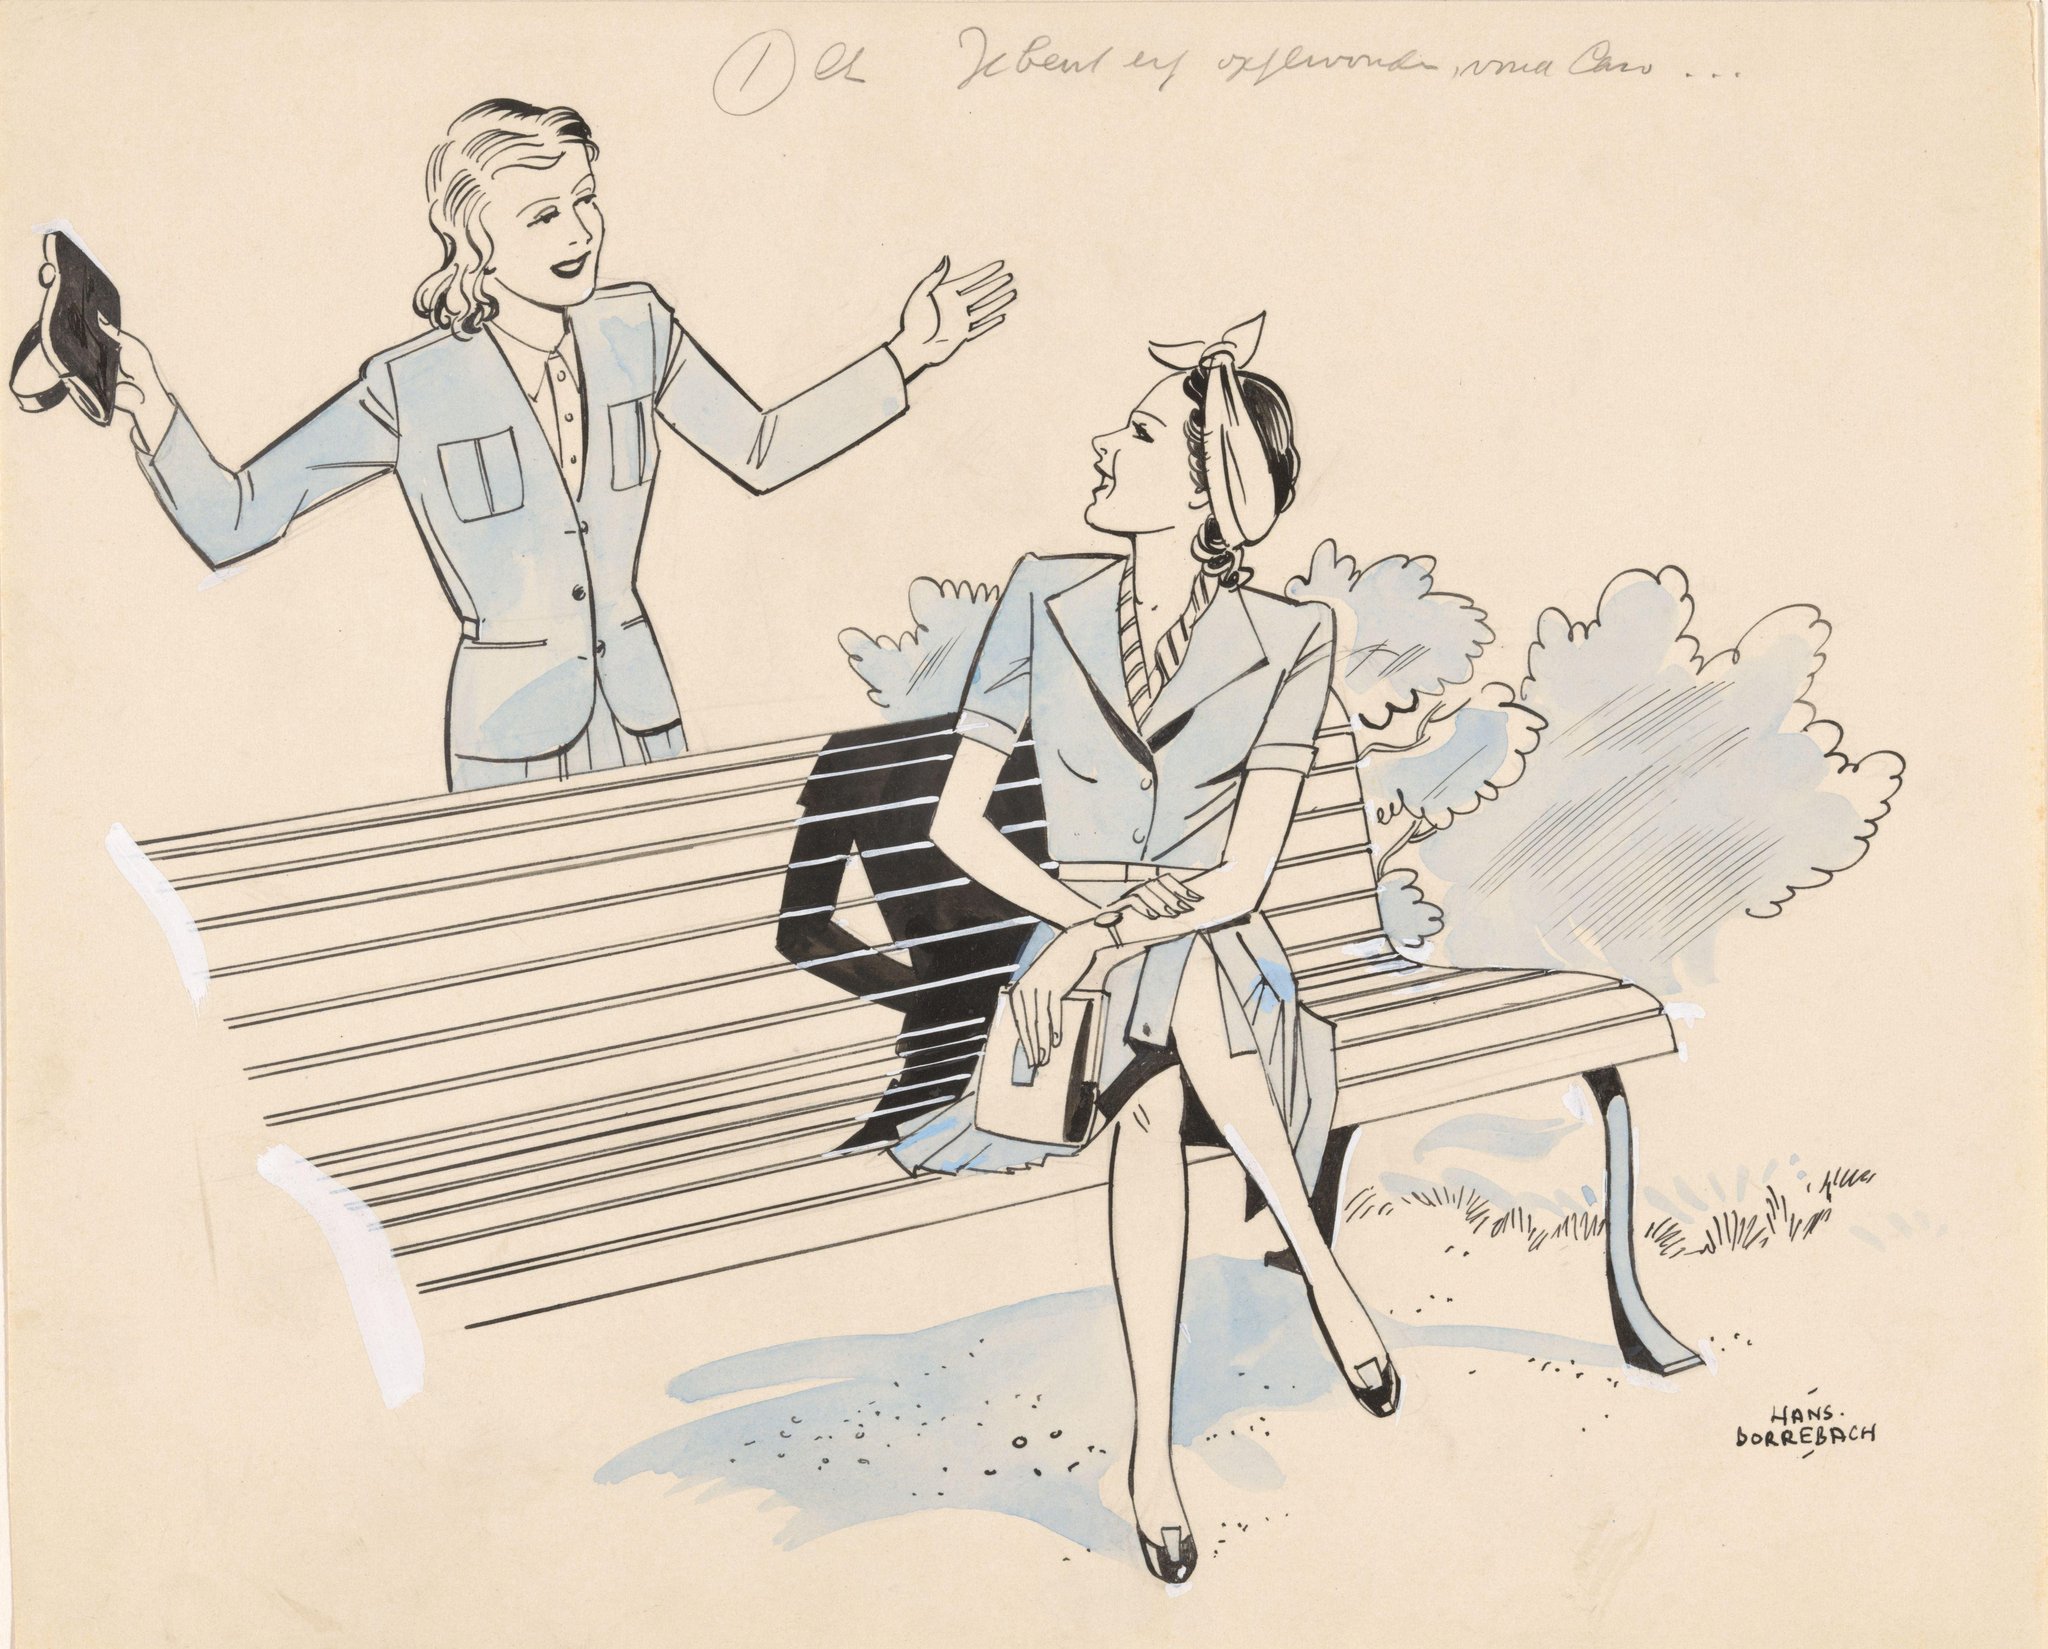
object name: boekillustratie ontwerp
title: Twee vrouwen in gesprek in een park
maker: hans borrebach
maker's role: draughtsman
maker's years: 1903-1991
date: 1940-1945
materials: paint, ink, paper, pencil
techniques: brush, pen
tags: park, bench, arm raised upward - aa - both arms or hands, conversation, dialogue; conversation piece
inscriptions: signature: ‘HANS./ BORREBACH’, collector's mark: ‘R:MVS’, annotation: ‘1 bl Je bent erg opgewonden, oma Caro . . .’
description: Ontwerp voor: Etten, Ine van. Idylle in de archipel. c. 1940. De eerste druk van het boek werd in 1940 gepubliceerd bij uitgeverij Valkhoff te Amersfoort. Het is onbekend voor welke druk het ontwerp is gemaakt.